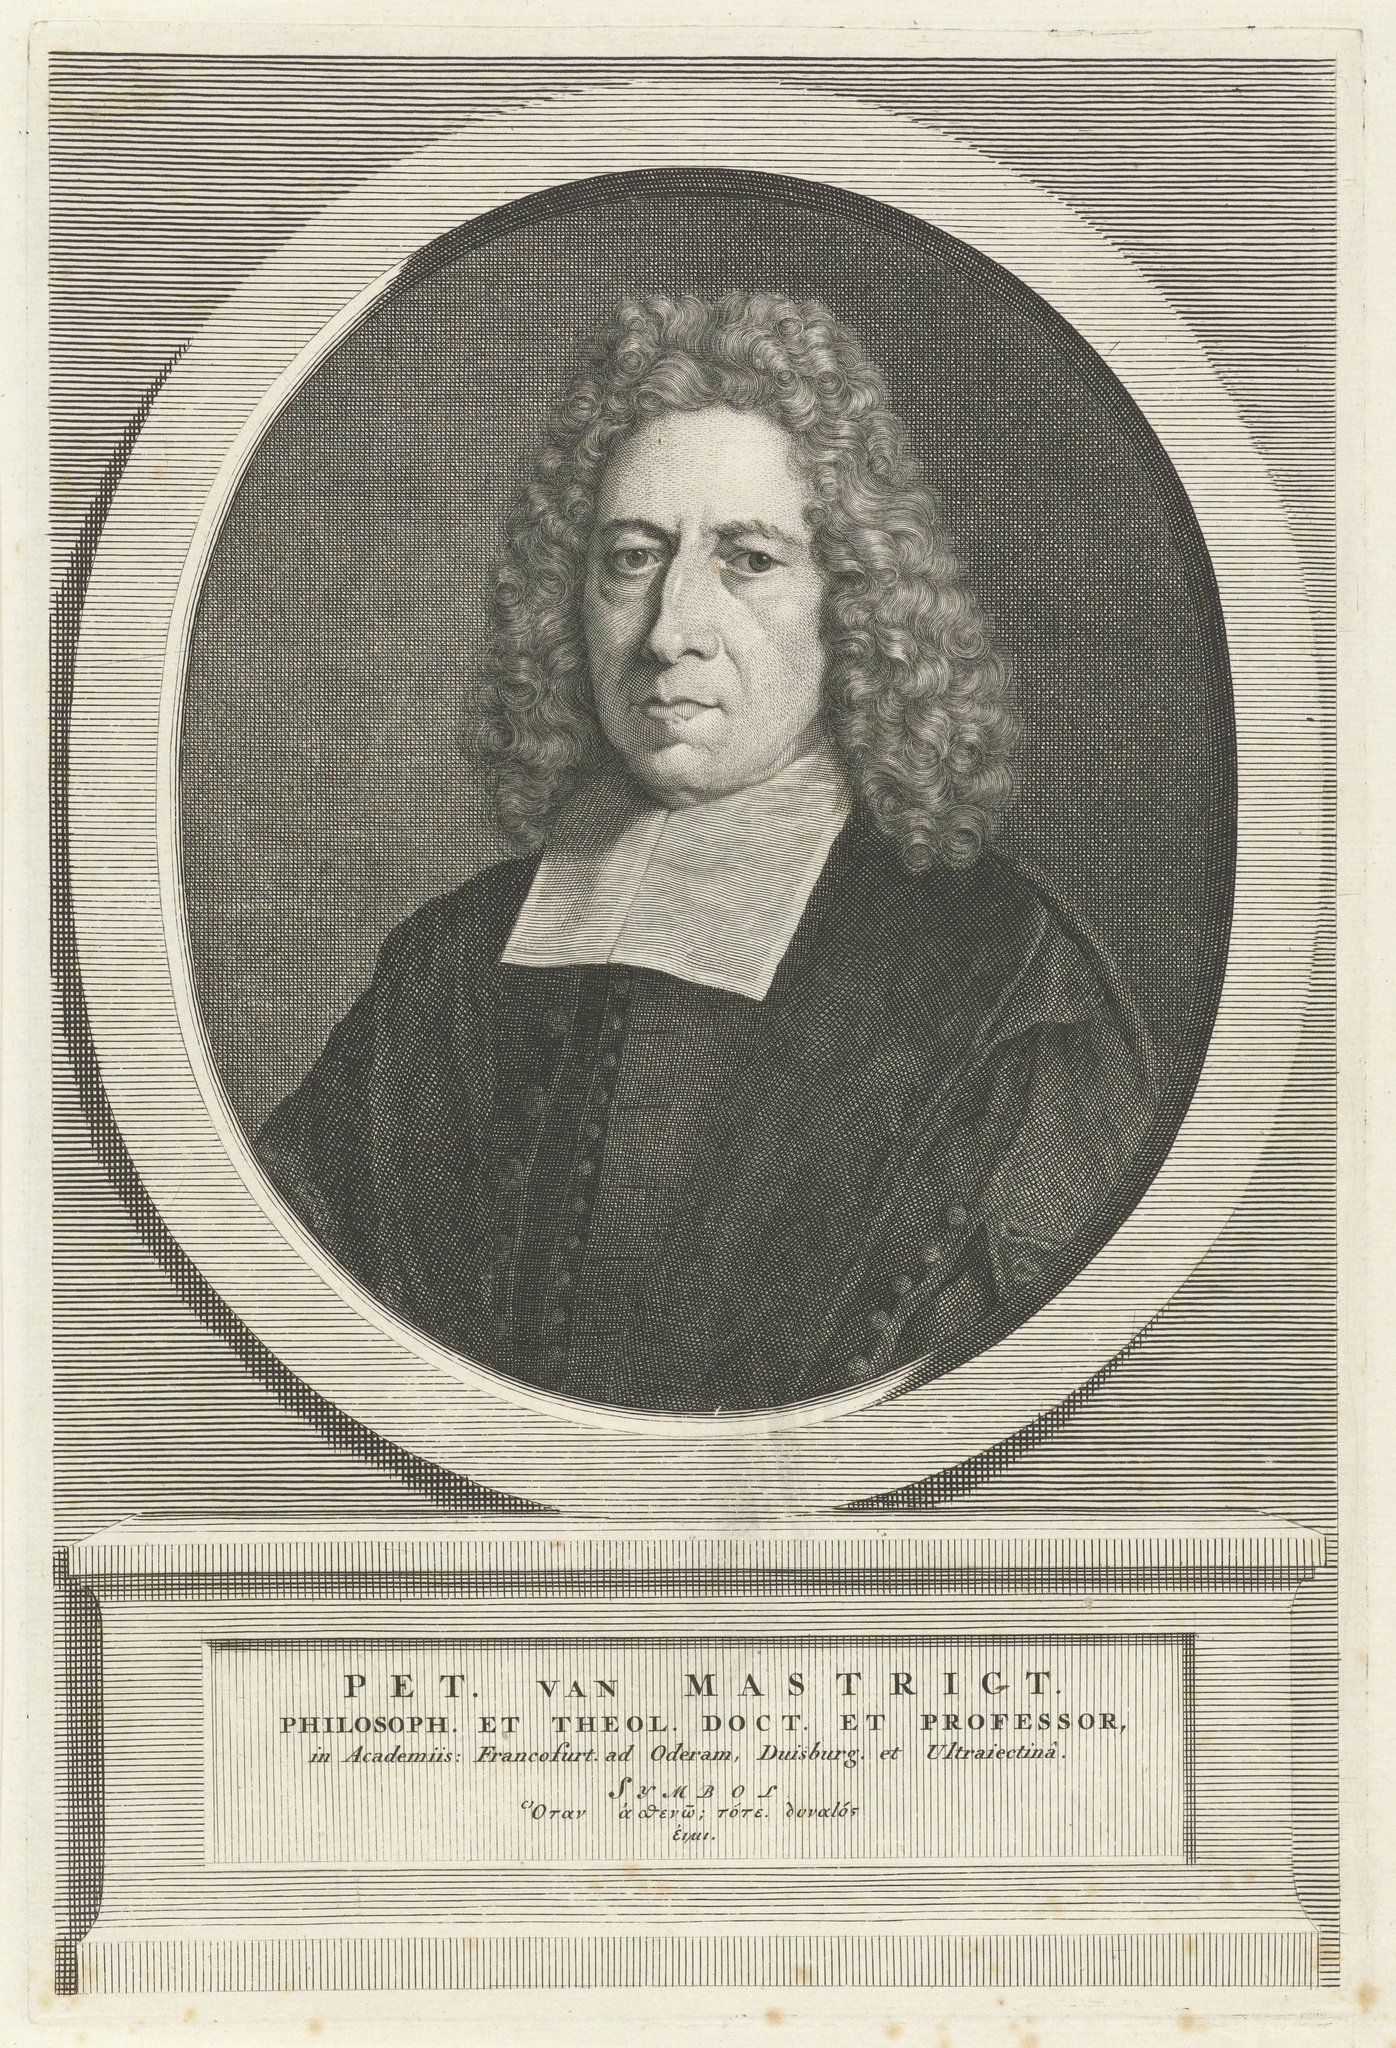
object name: print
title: Portret van Petrus van Maastricht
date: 1659-1731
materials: paper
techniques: engraving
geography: amsterdam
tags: cologne, utrecht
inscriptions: collector's mark: Lugt 2228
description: Petrus van Maastricht, hoogleraar theologie en filosofie in Frankfurt, Duisburg en Utrecht. Met Latijns en Grieks onderschrift.